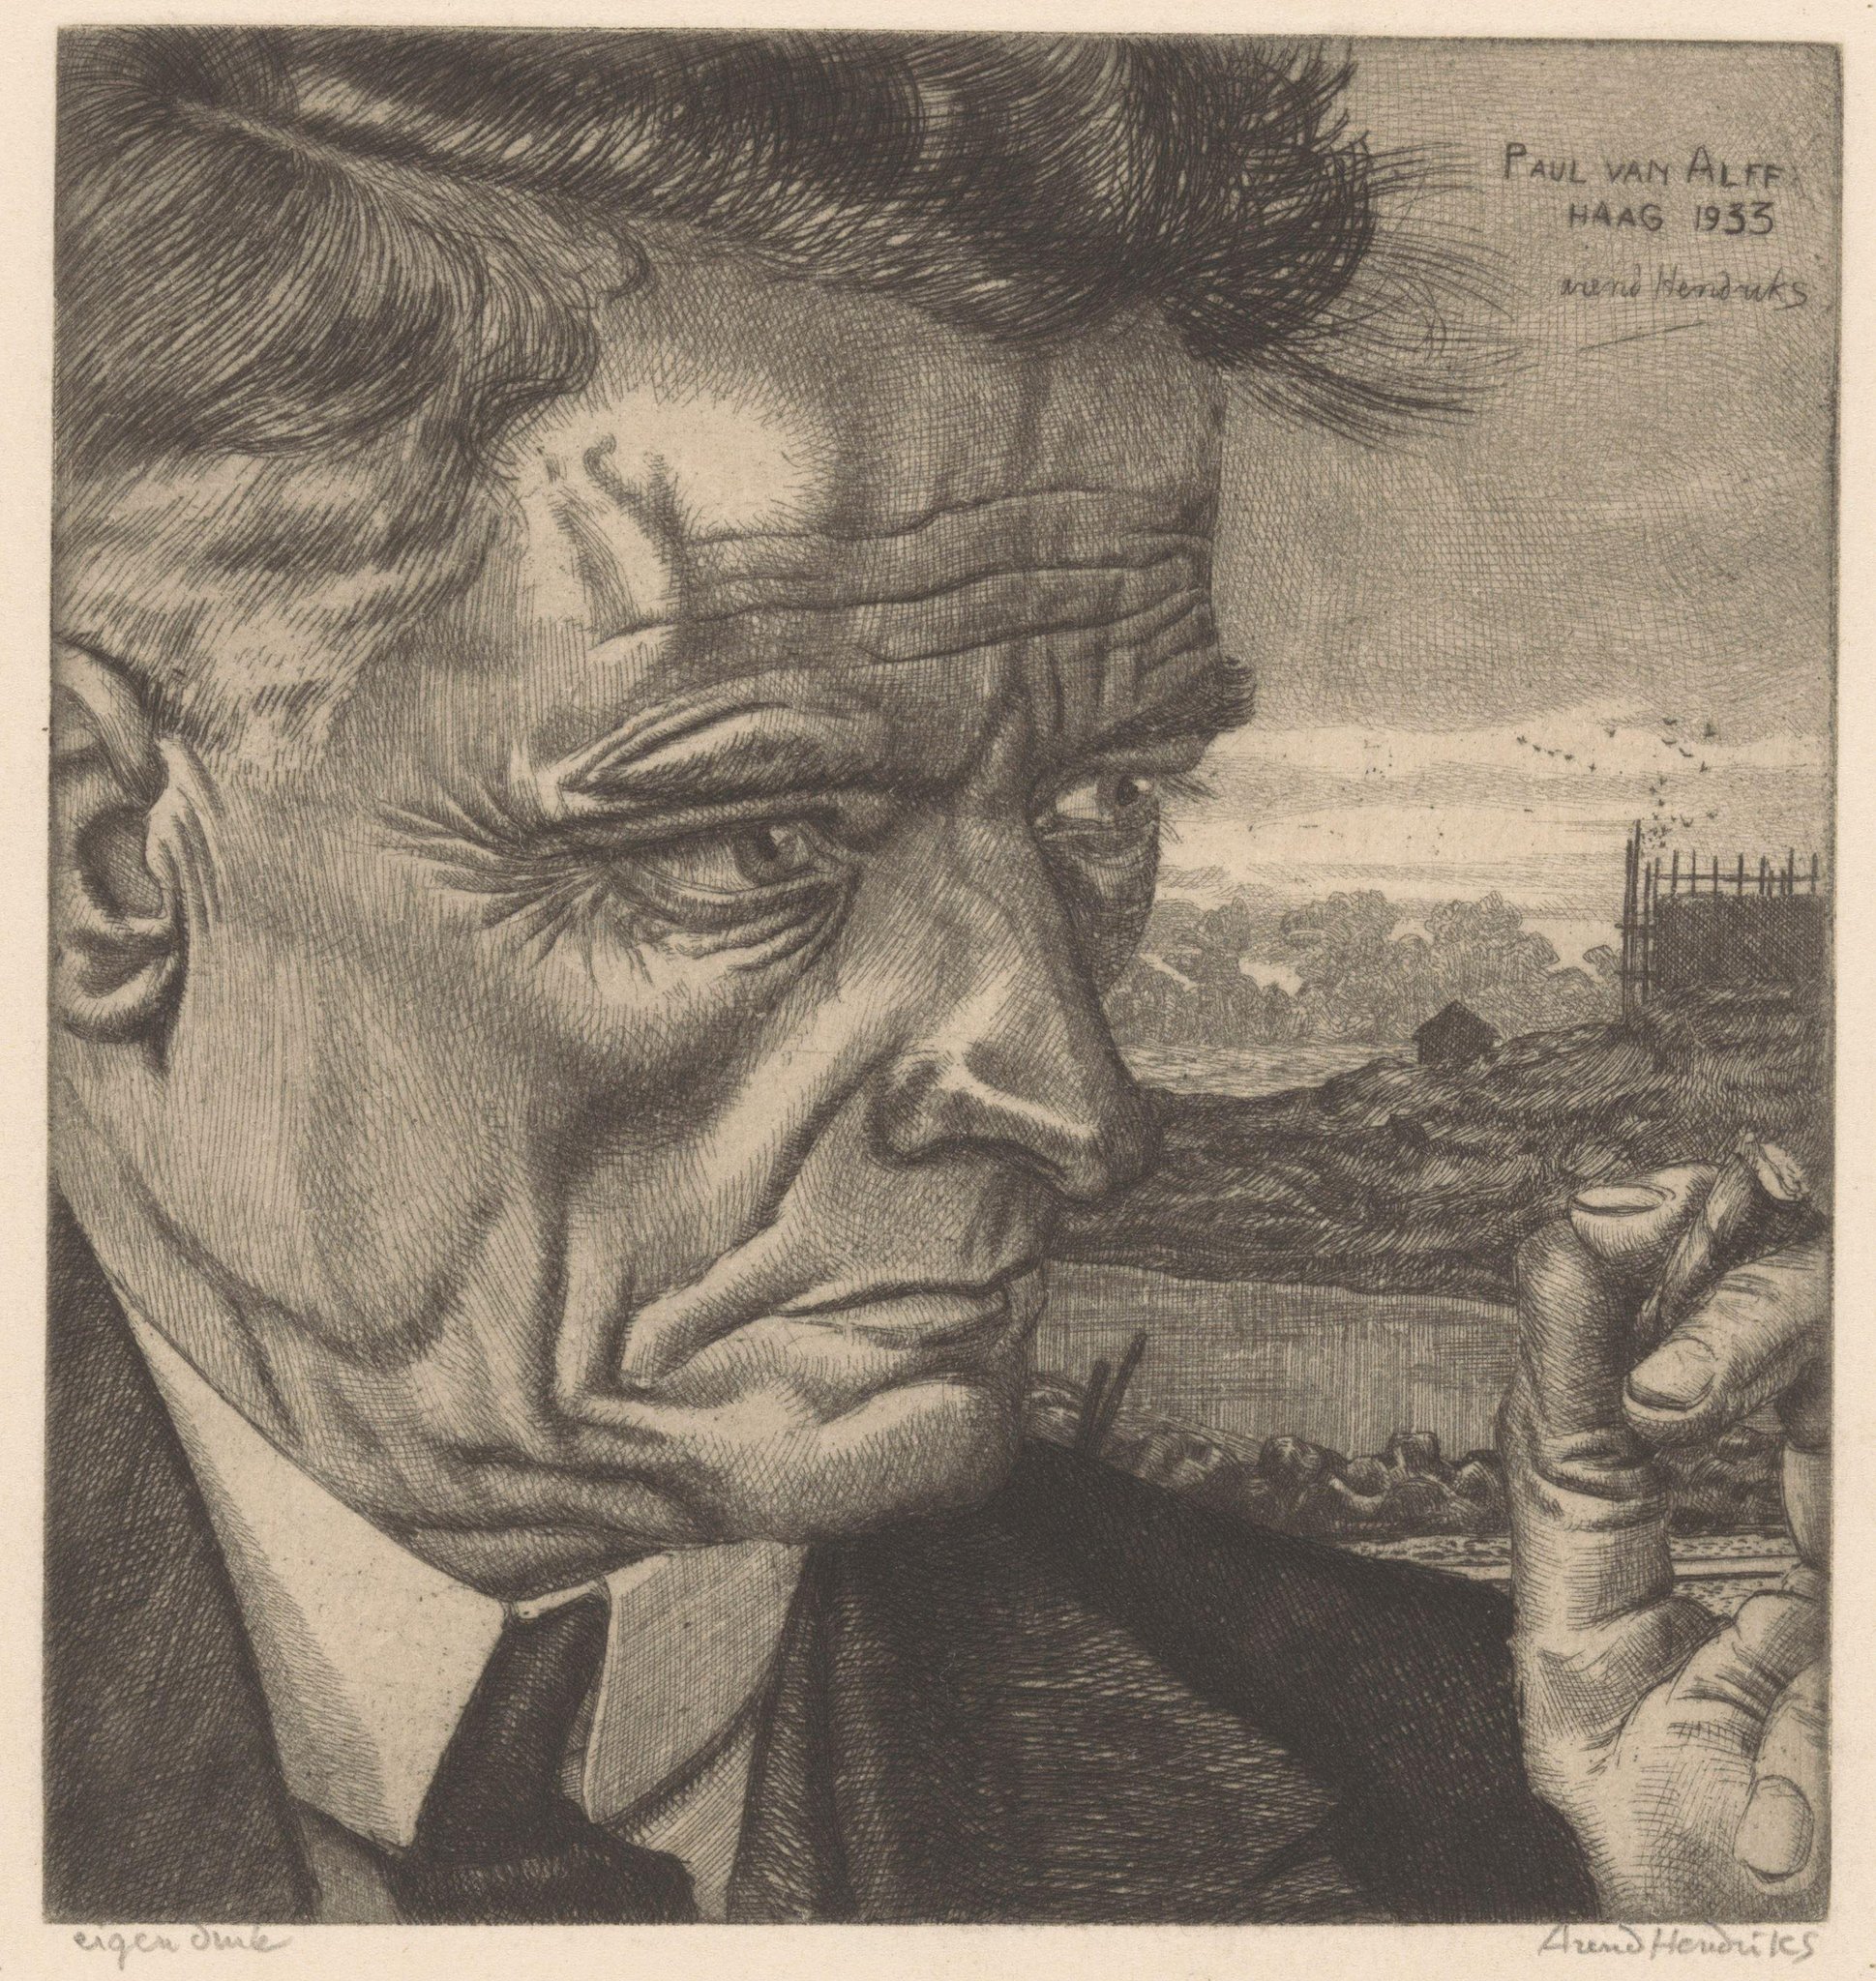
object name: print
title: Portret van Paul van Alff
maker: arend hendriks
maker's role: print maker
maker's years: 1901-1951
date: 1933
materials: paper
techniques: etching, intaglio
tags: the hague, print maker, paulus nicolaas van alff, landscapes with waters, waterscapes, seascapes (in the temperate zone), portrait, self-portrait of artist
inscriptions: collector's mark: Lugt 2228, inscription: ‘Paul. N. van Alff. [...] Heeft niet gegeven wat van hem verwacht werd.’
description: Een portret van kunstenaar Paul van Alff in een landschap met water.